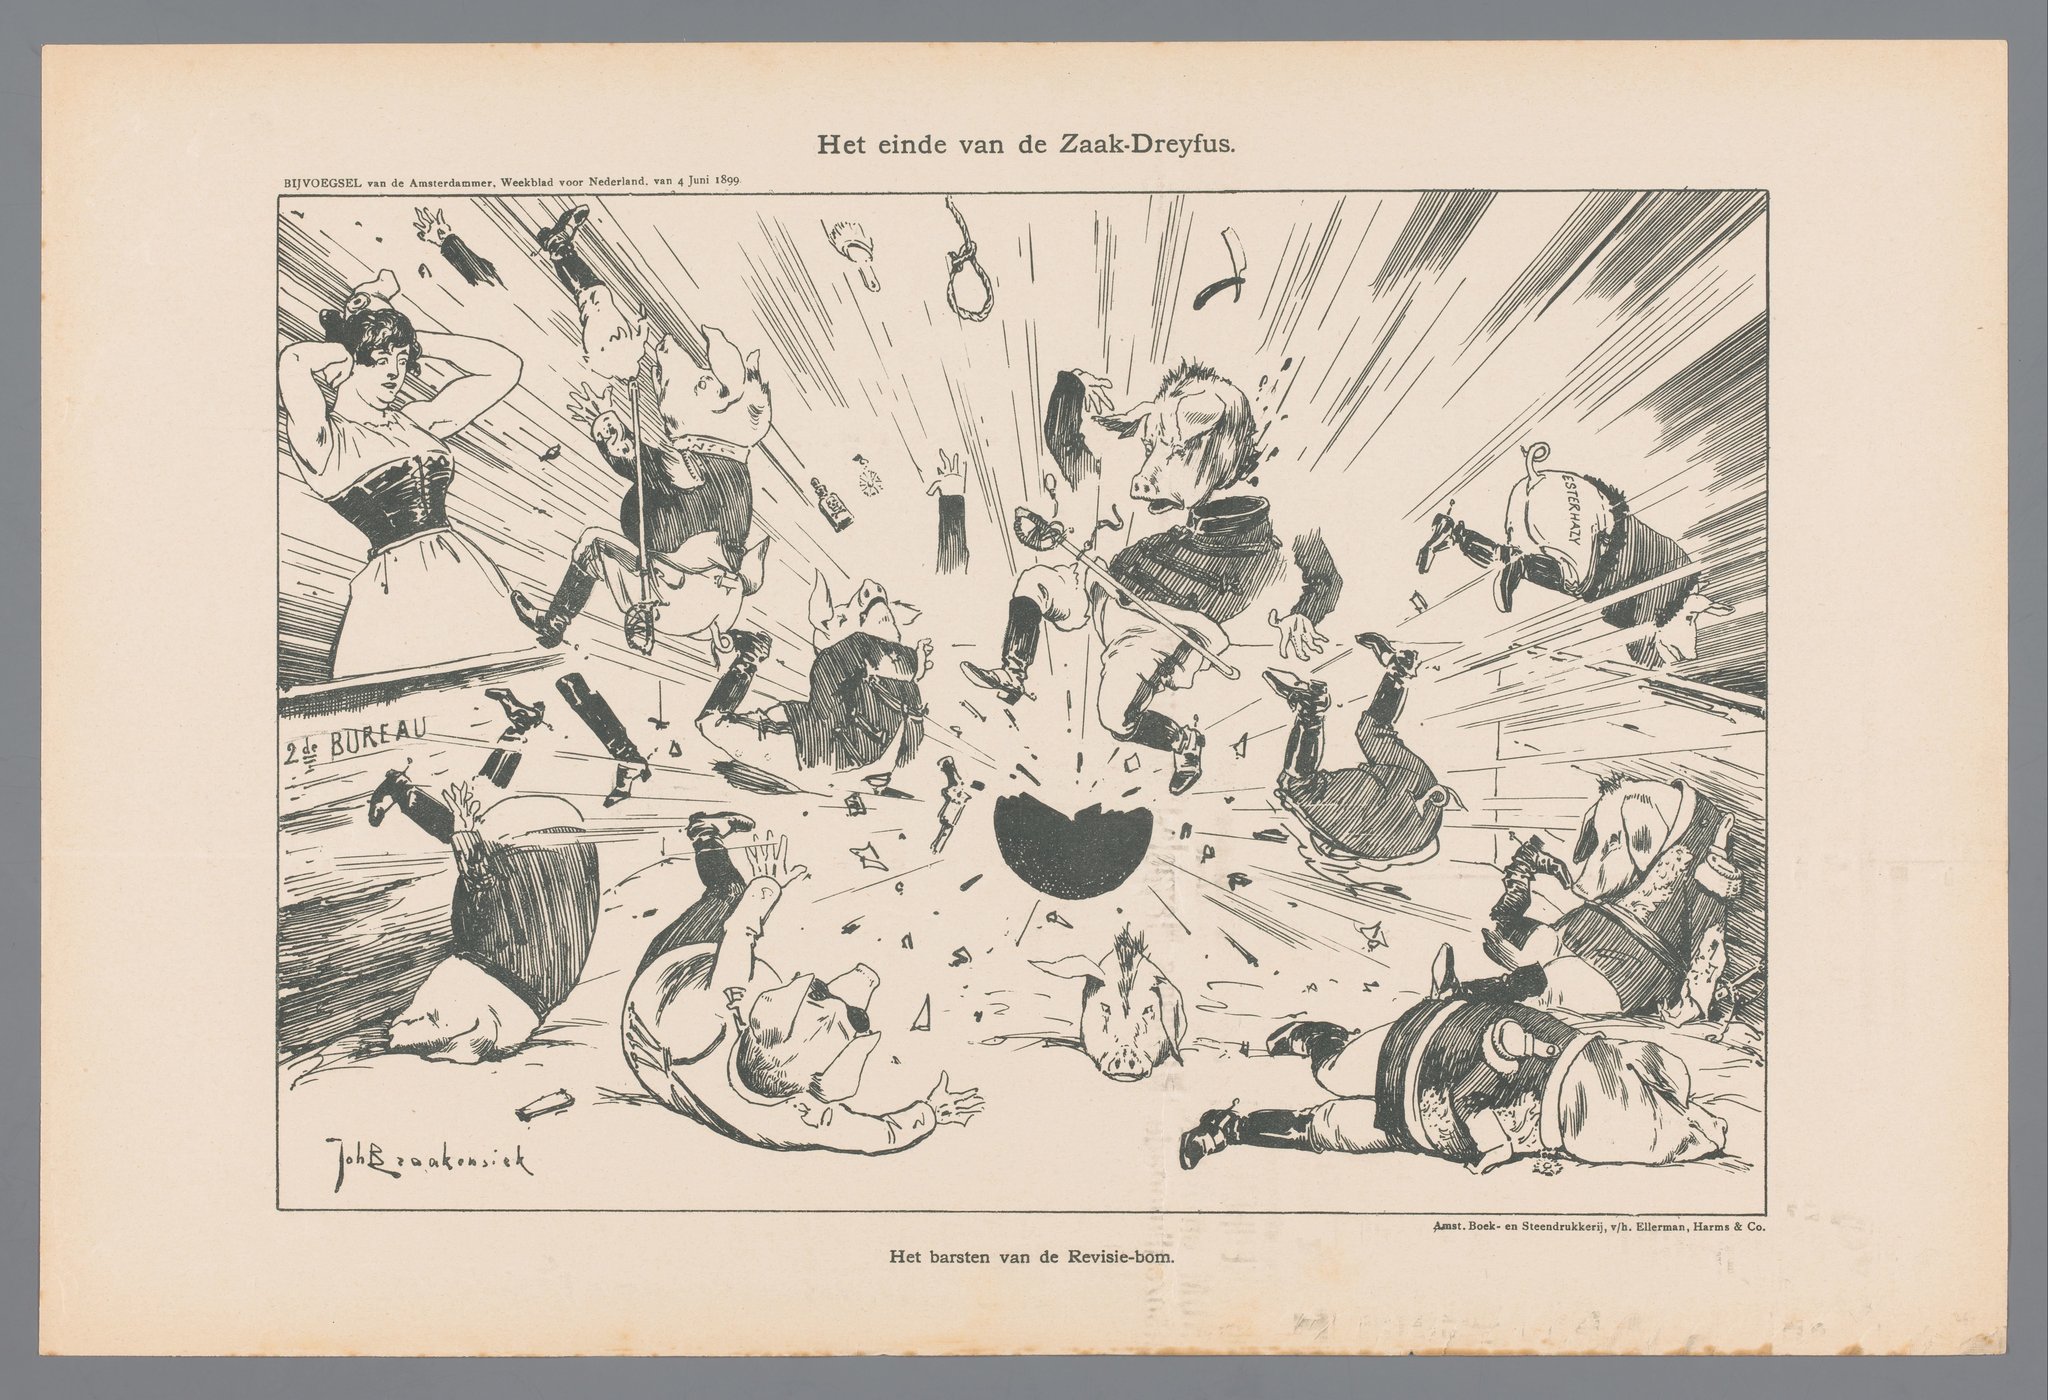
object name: cartoon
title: Het einde van de Zaak-Dreyfus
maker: johan braakensiek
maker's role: draughtsman, print maker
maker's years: 1858-1940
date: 1899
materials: paper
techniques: lithograph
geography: amsterdam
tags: pig, violent death by bomb, hand-grenade, political caricatures and satires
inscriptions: date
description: Prent uit het bijvoegsel van: De Amsterdammer. Weekblad voor Nederland, 4 juni 1899.